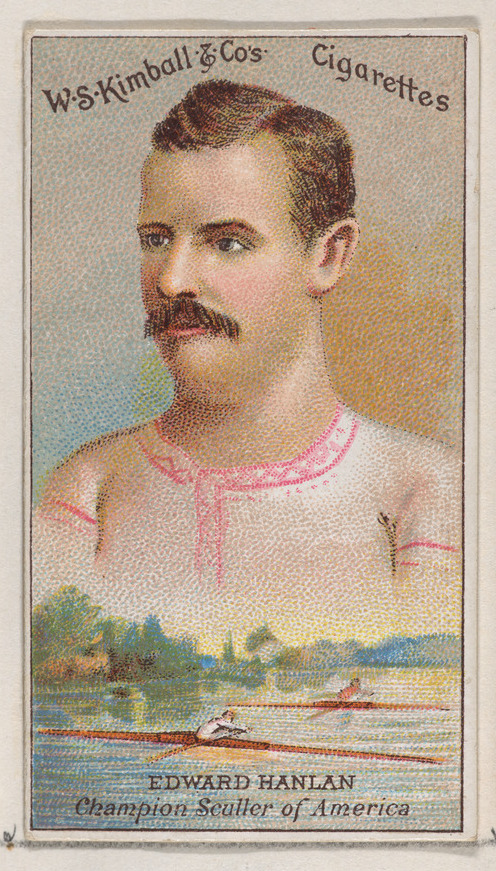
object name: print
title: Edward Hanlan, Champion Sculler of America, from the Champions of Games and Sports series (N184, Type 1) issued by W.S. Kimball & Co.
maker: w.s. kimball & co.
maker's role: publisher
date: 1887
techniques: color lithograph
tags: men,rowing,athletes